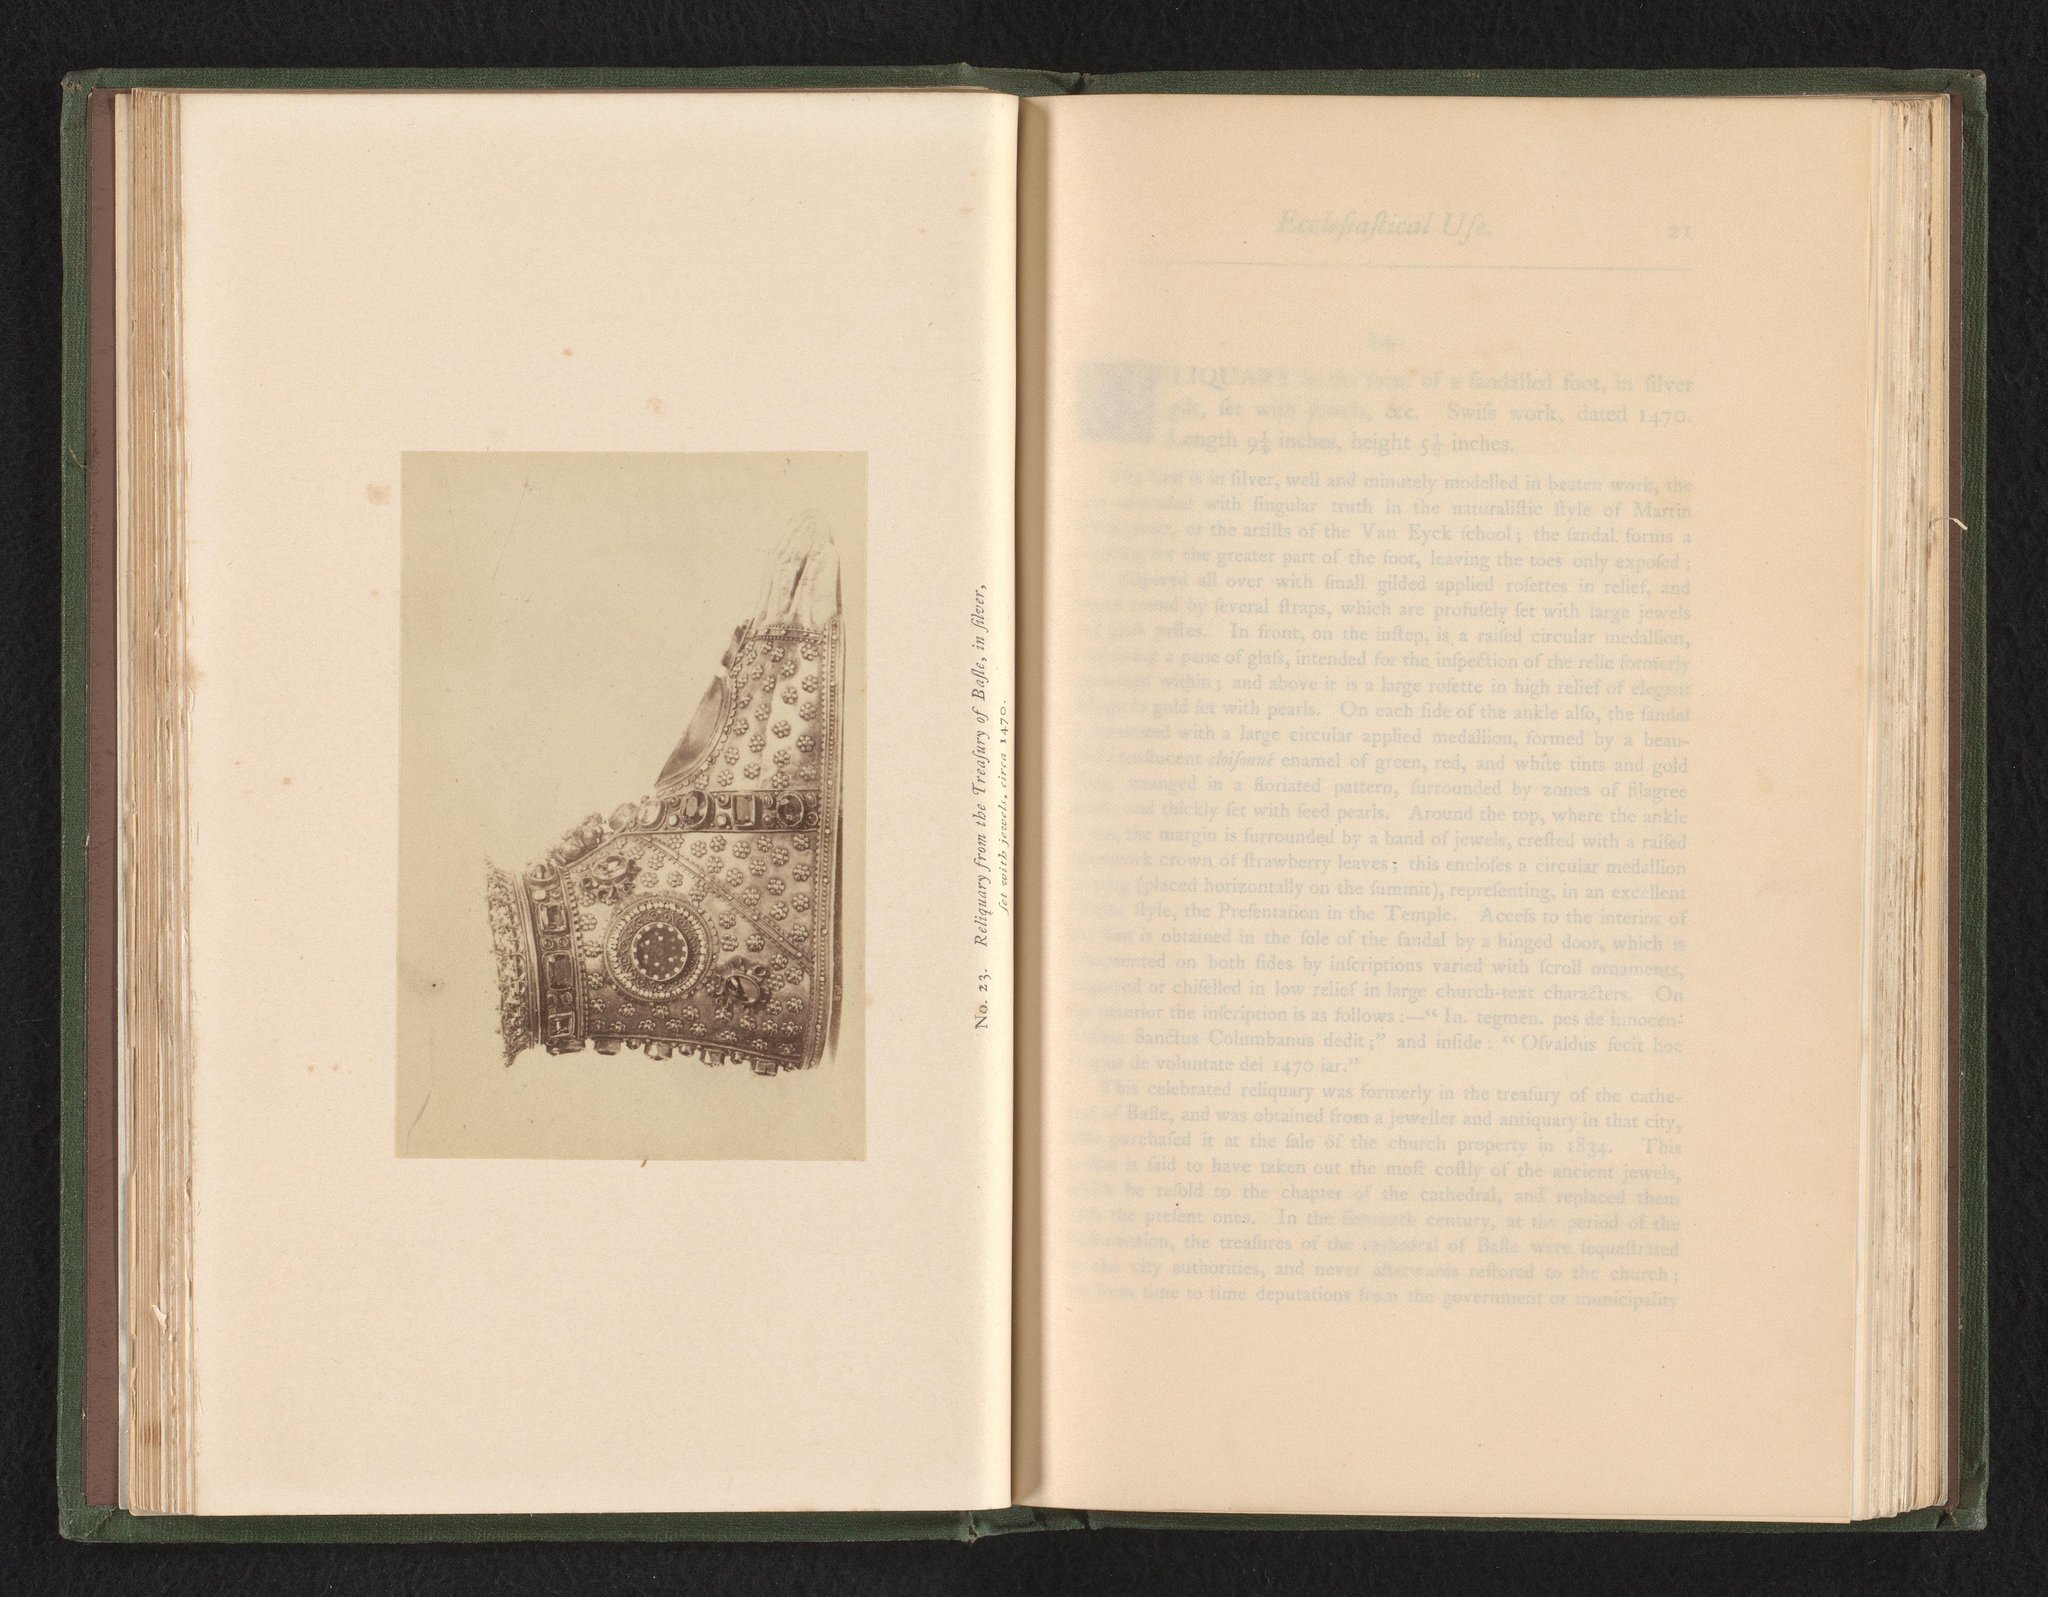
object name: photograph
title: Reliquary from the Treasury of Bafle, in silver, set with jewels, circa 1470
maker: Anonymous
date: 1856-1861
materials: paper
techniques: albumen print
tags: relics (and reliquaries)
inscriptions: number: ‘No. 23.’